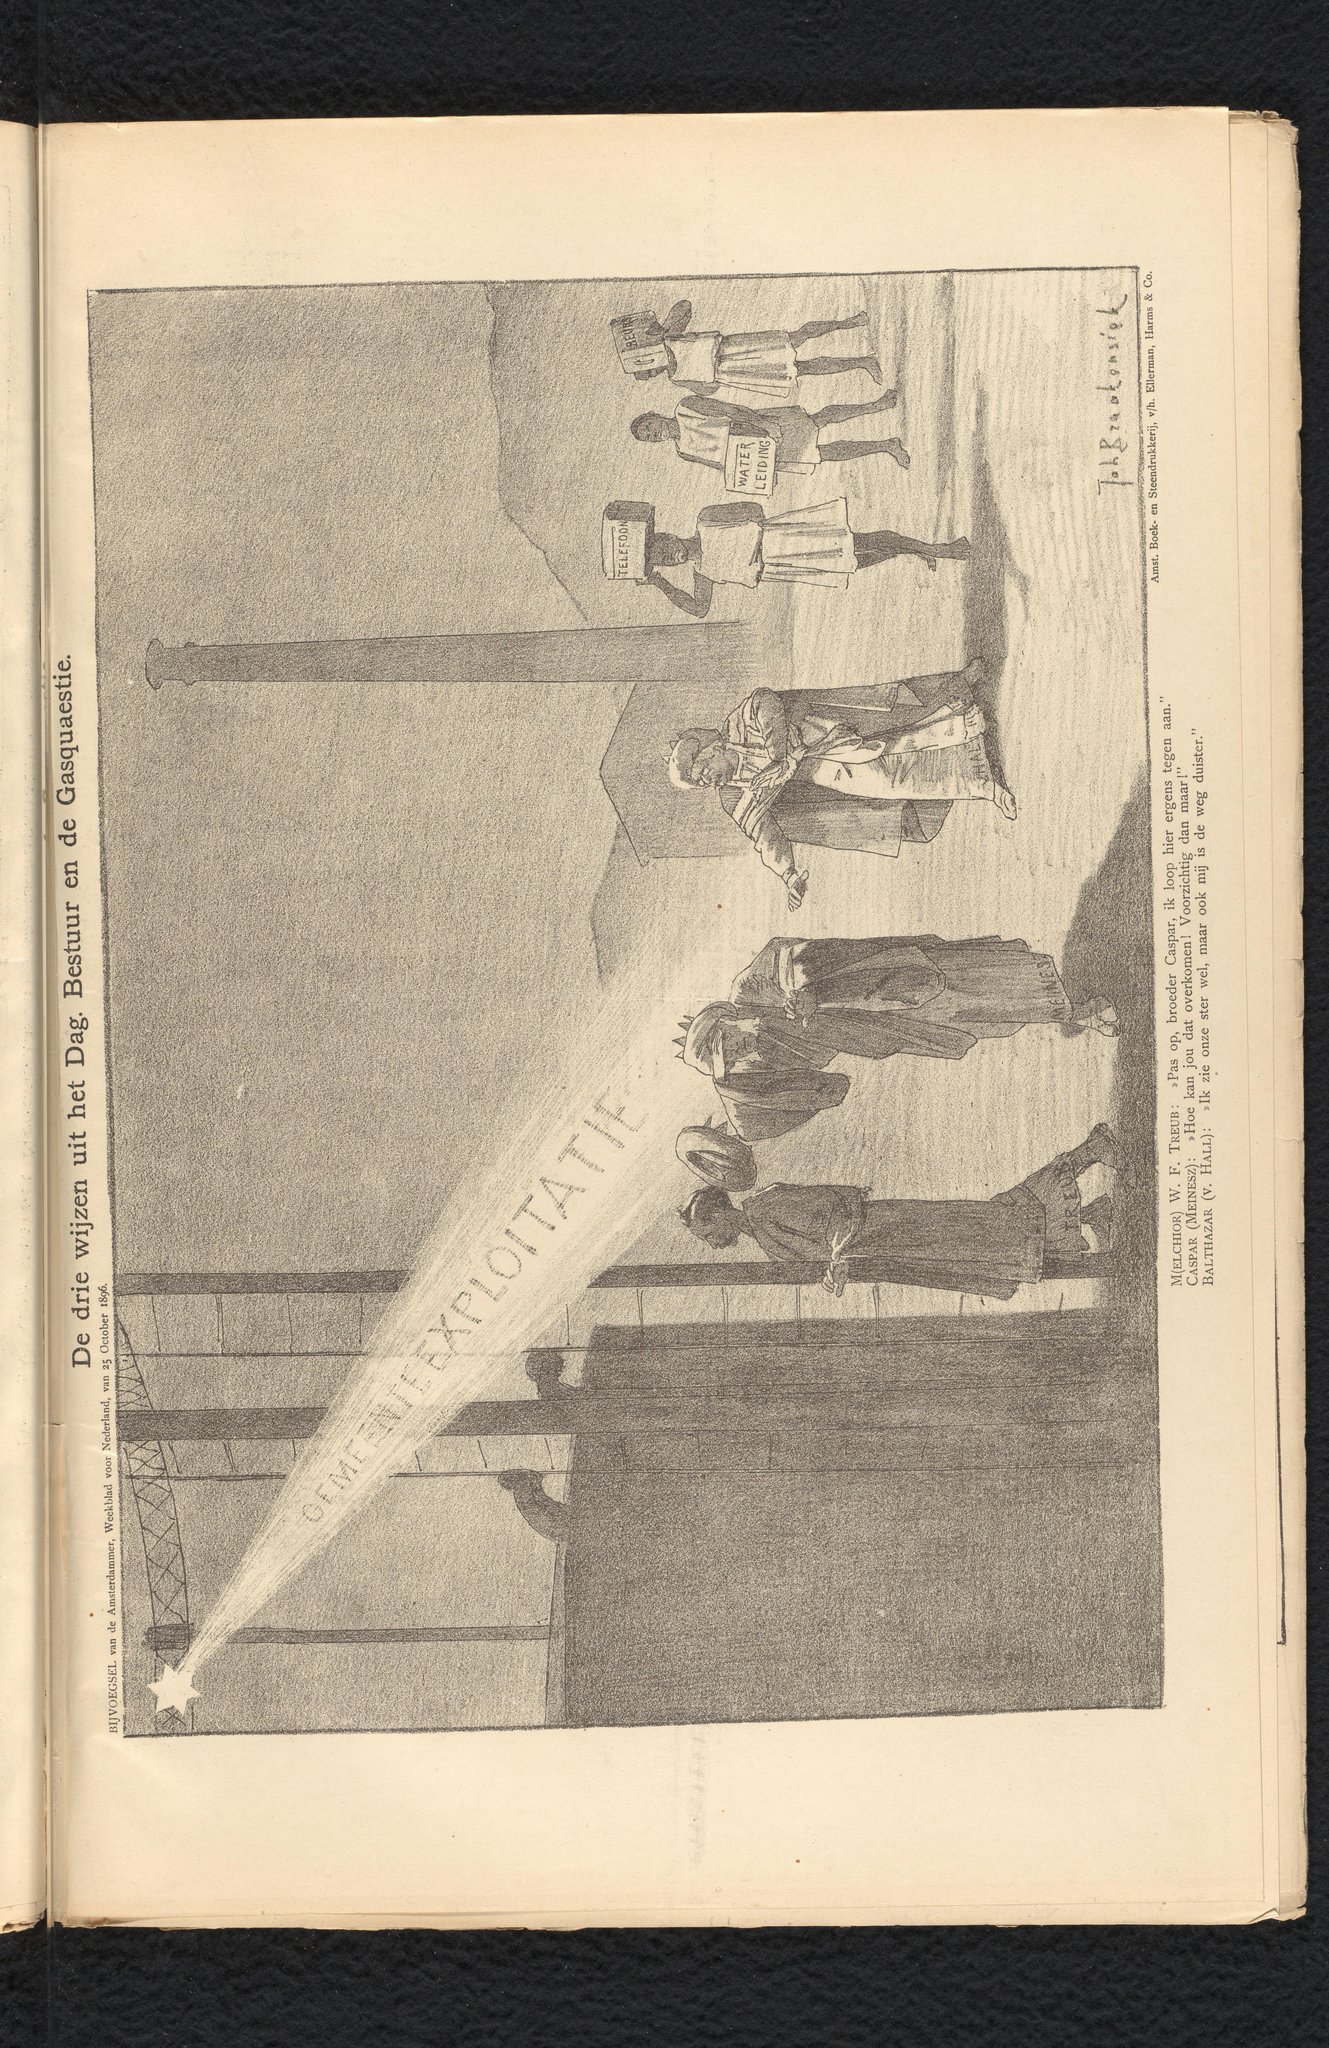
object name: cartoon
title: De drie wijzen uit het Dag. Bestuur en de Gasquaestie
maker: johan braakensiek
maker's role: draughtsman, print maker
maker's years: 1858-1940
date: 1896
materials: paper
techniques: lithograph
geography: amsterdam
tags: harlingen, voorschoten, the hague, politician, jacob nicolaas van hall, the story of the three wise men (kings or magi) (matthew 2:1-12), telephone, water-supply (~ public services), gas supply, amsterdam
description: Amsterdamse wethouders Treub, van Hall en burgemeester Meinesz als de drie wijzen uit het oosten die de ster van de 'Gemeente exploitatie' van de gemeentelijke gasvoorziening volgen. Achter hen volgen drie dragers met pakketten gemerkt: telefonie, waterleiding en beurs.